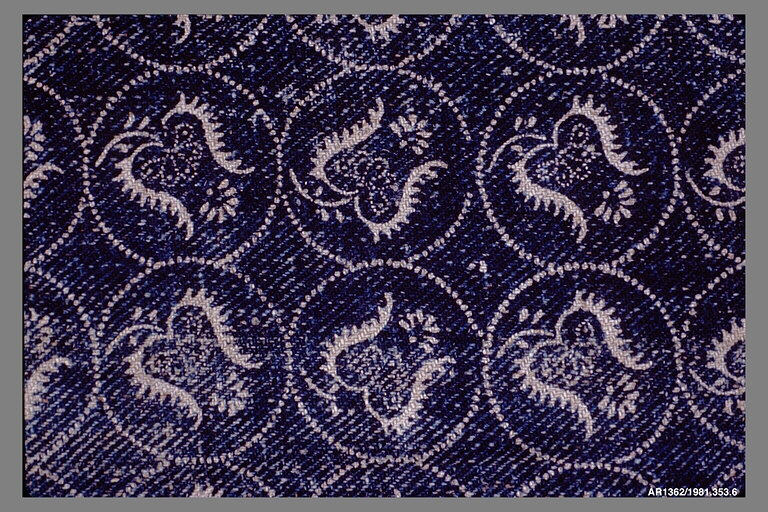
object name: piece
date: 1701-1800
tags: flowers